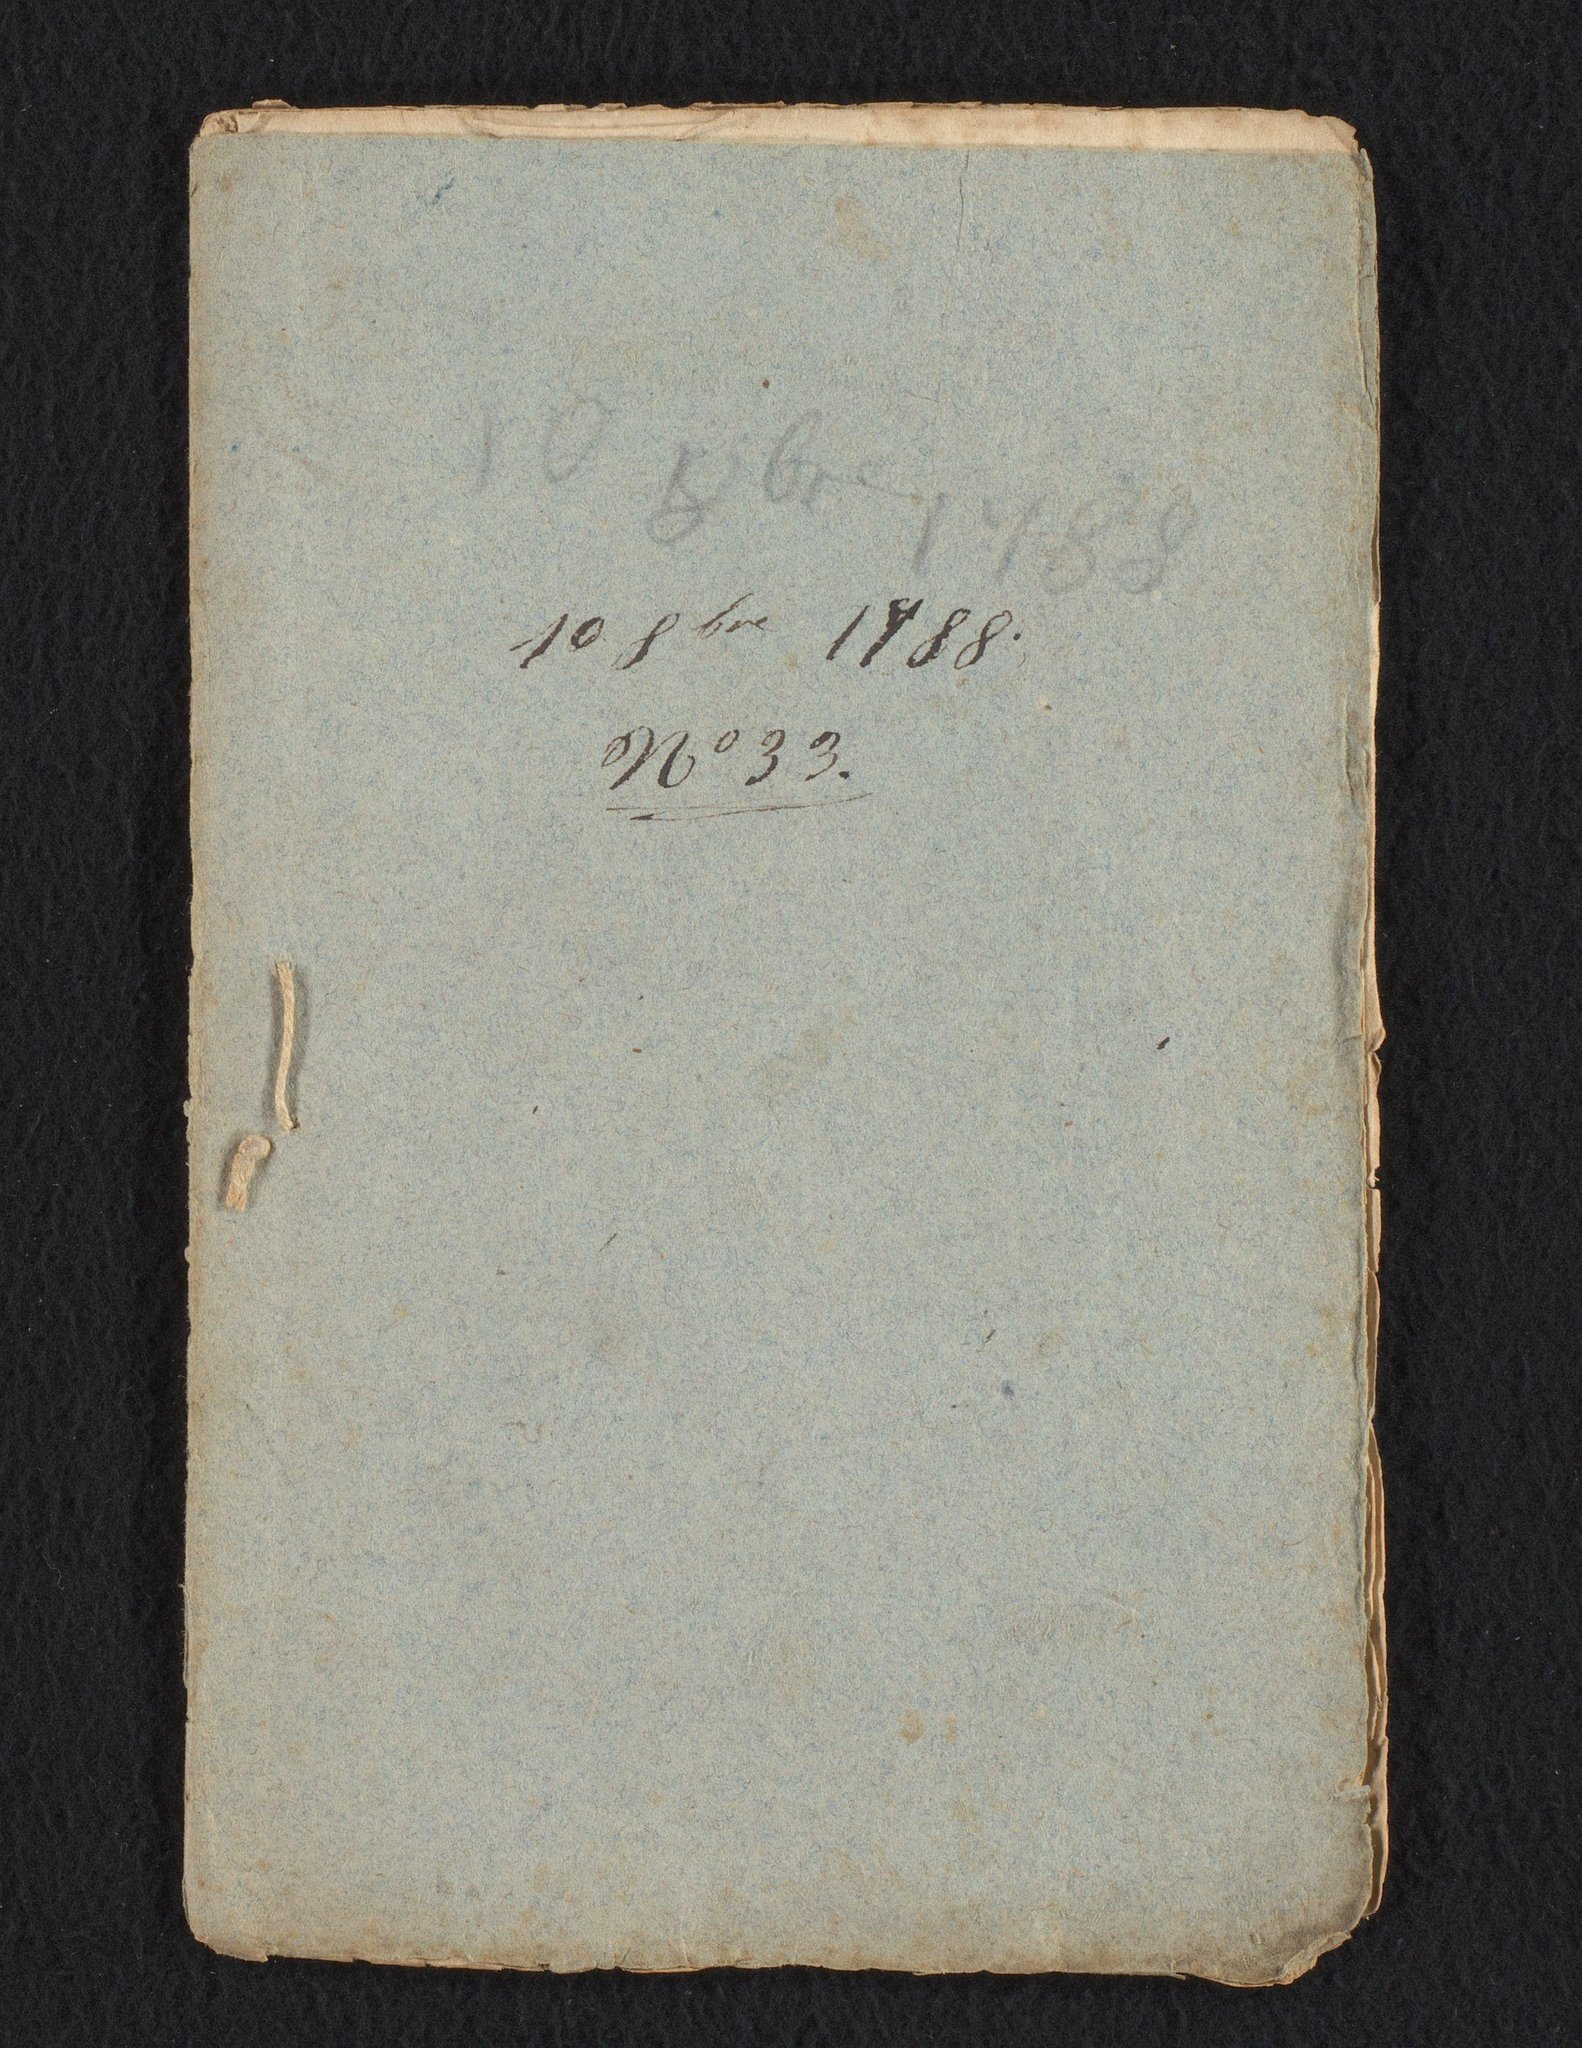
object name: magazine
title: Magasin des Modes Nouvelles Françaises et Anglaises, 10 octobre 1788, 33e cahier, 3e année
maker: buisson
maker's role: publisher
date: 1788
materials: paper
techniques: engraving, hand coloring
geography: paris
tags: fashion plates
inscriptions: date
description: 33e Cahier, 10 octobre 1788, (Troisième Année) pp. 260-266 + 1 prent in drieën gevouwen. Cahier uit het modetijdschrift Magasin des Modes Nouvelles Françaises et Anglaises, Parijs, 20 november 1786 - 21 décembre 1789.